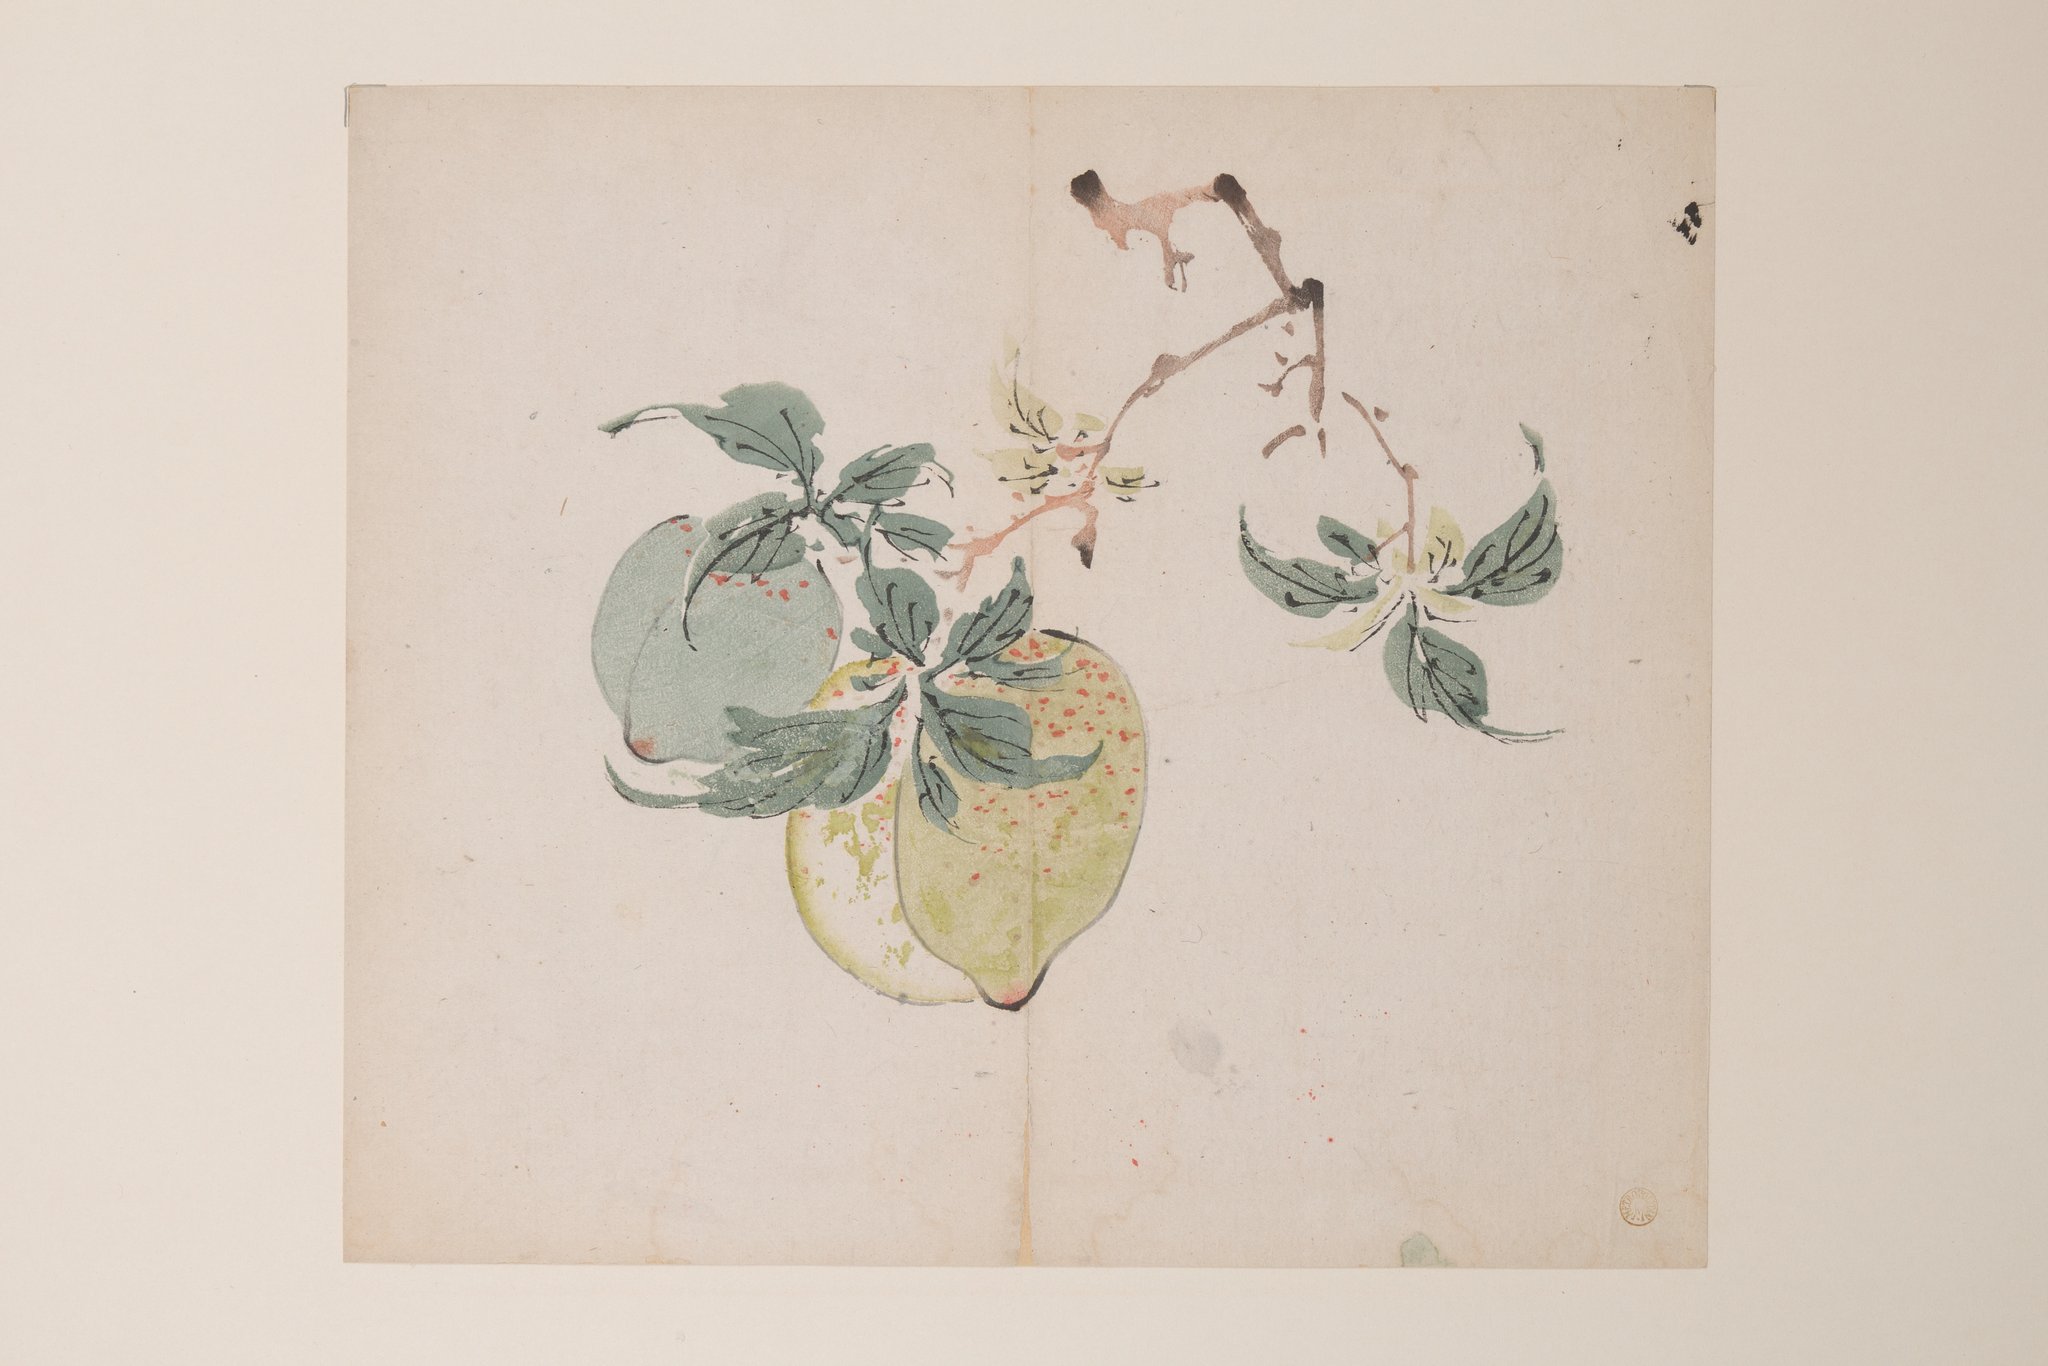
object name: print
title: Page from the Ten Bamboo Studio Manual of Painting and Calligraphy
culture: chinese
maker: hu zhengyan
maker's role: artist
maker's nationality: chinese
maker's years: 1584-1634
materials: ink, paper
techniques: printing